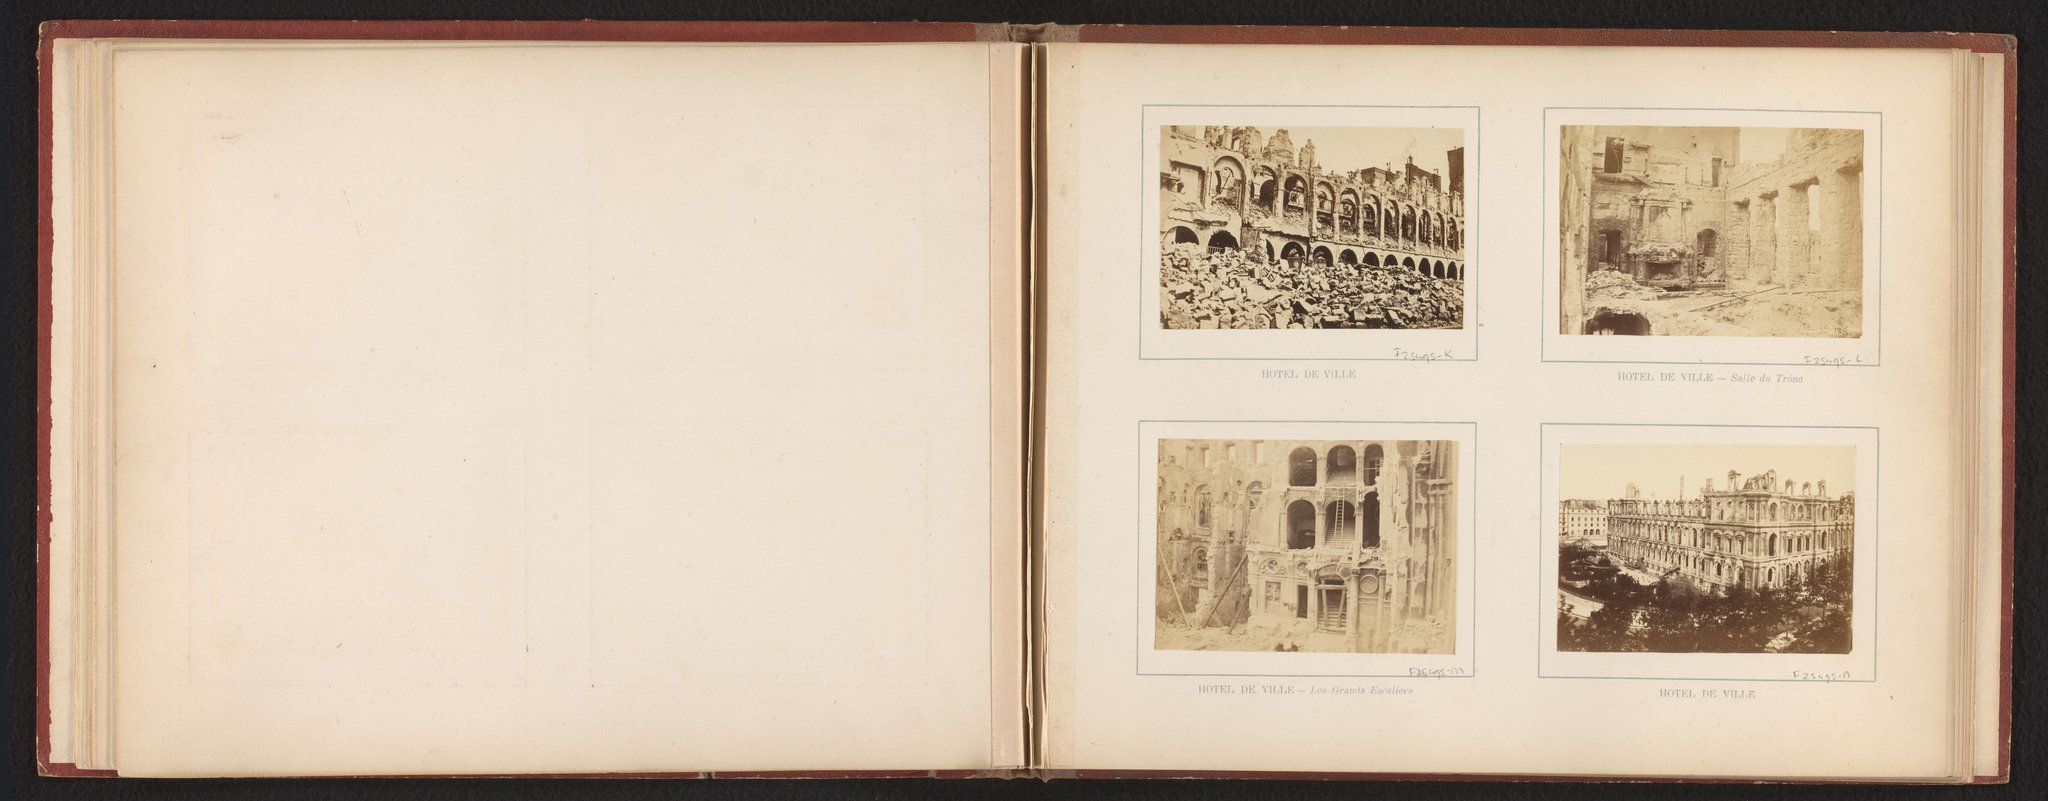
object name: page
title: Hotel de Ville - Salle du Trône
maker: Anonymous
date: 1871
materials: paper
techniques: albumen print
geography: paris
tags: ruin of a building ~ architecture